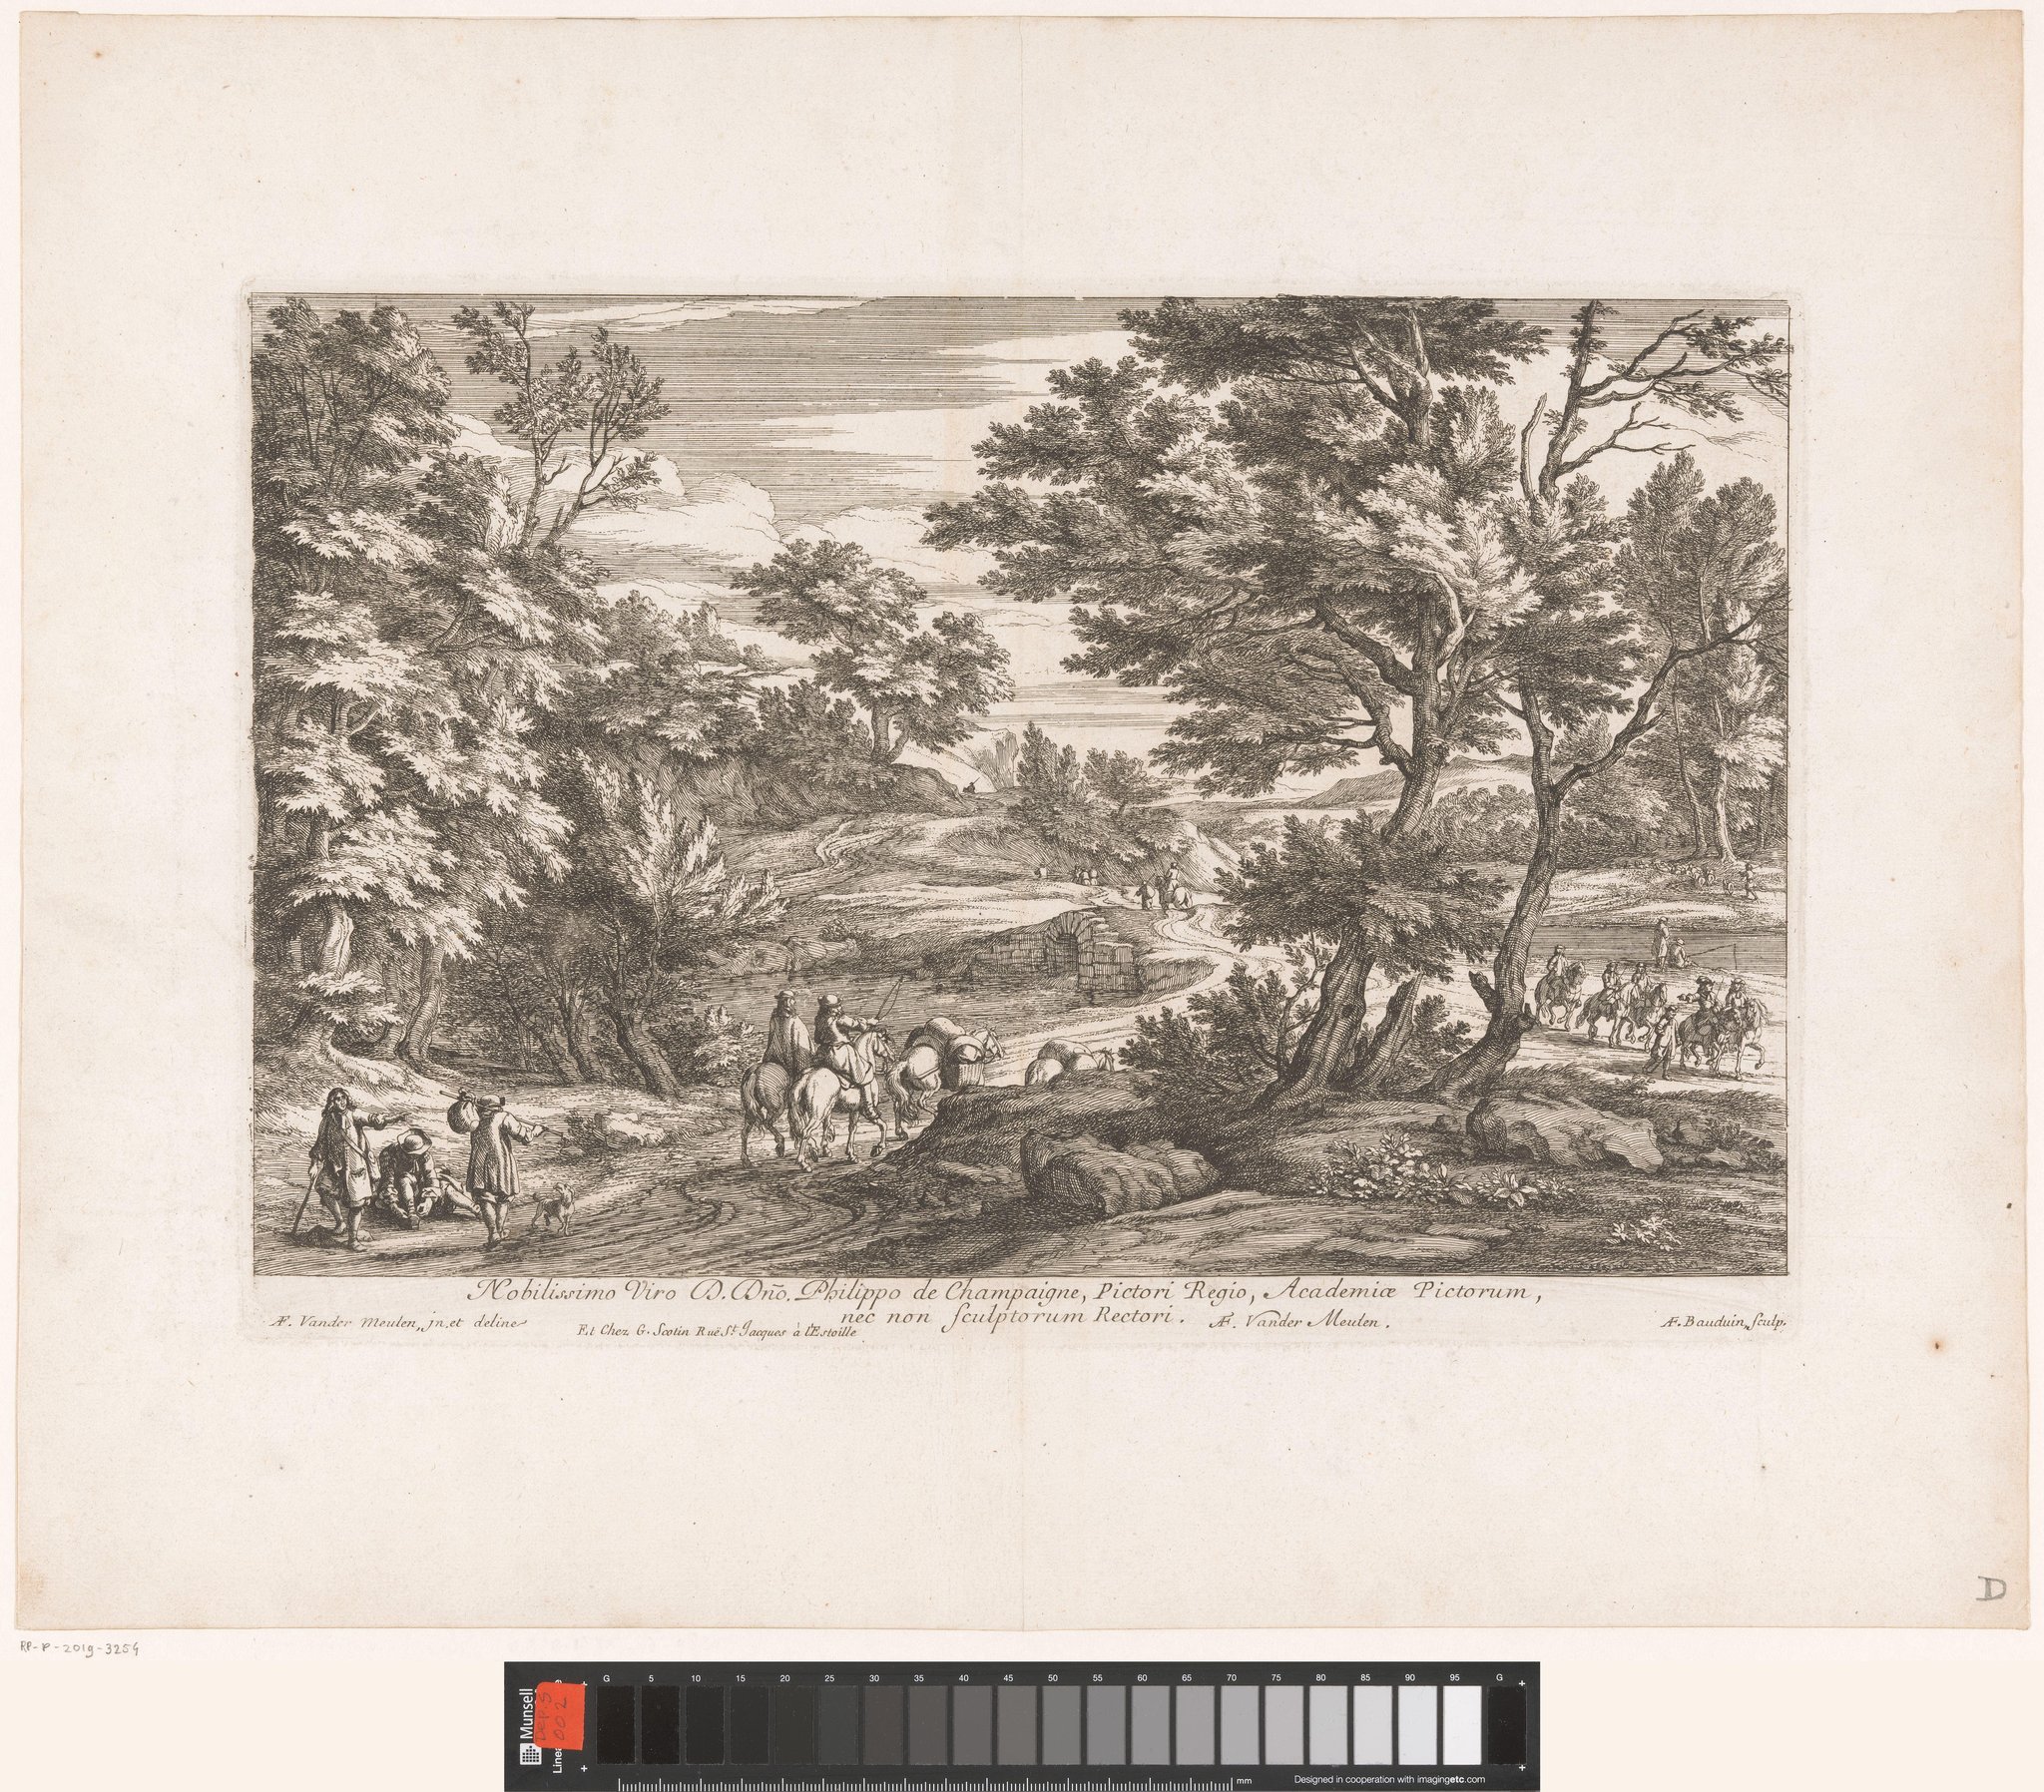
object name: print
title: Landschappen met reizigers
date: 1664-1674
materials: paper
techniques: etching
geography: paris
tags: river (+ landscape with figures, staffage)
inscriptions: collector's mark: Lugt 2228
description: Maakt deel uit van een zesdelige serie met landschappen met reizigers. De eerste plaat draagt een opdracht aan Philippe de Champaigne die in 1674 overleed.